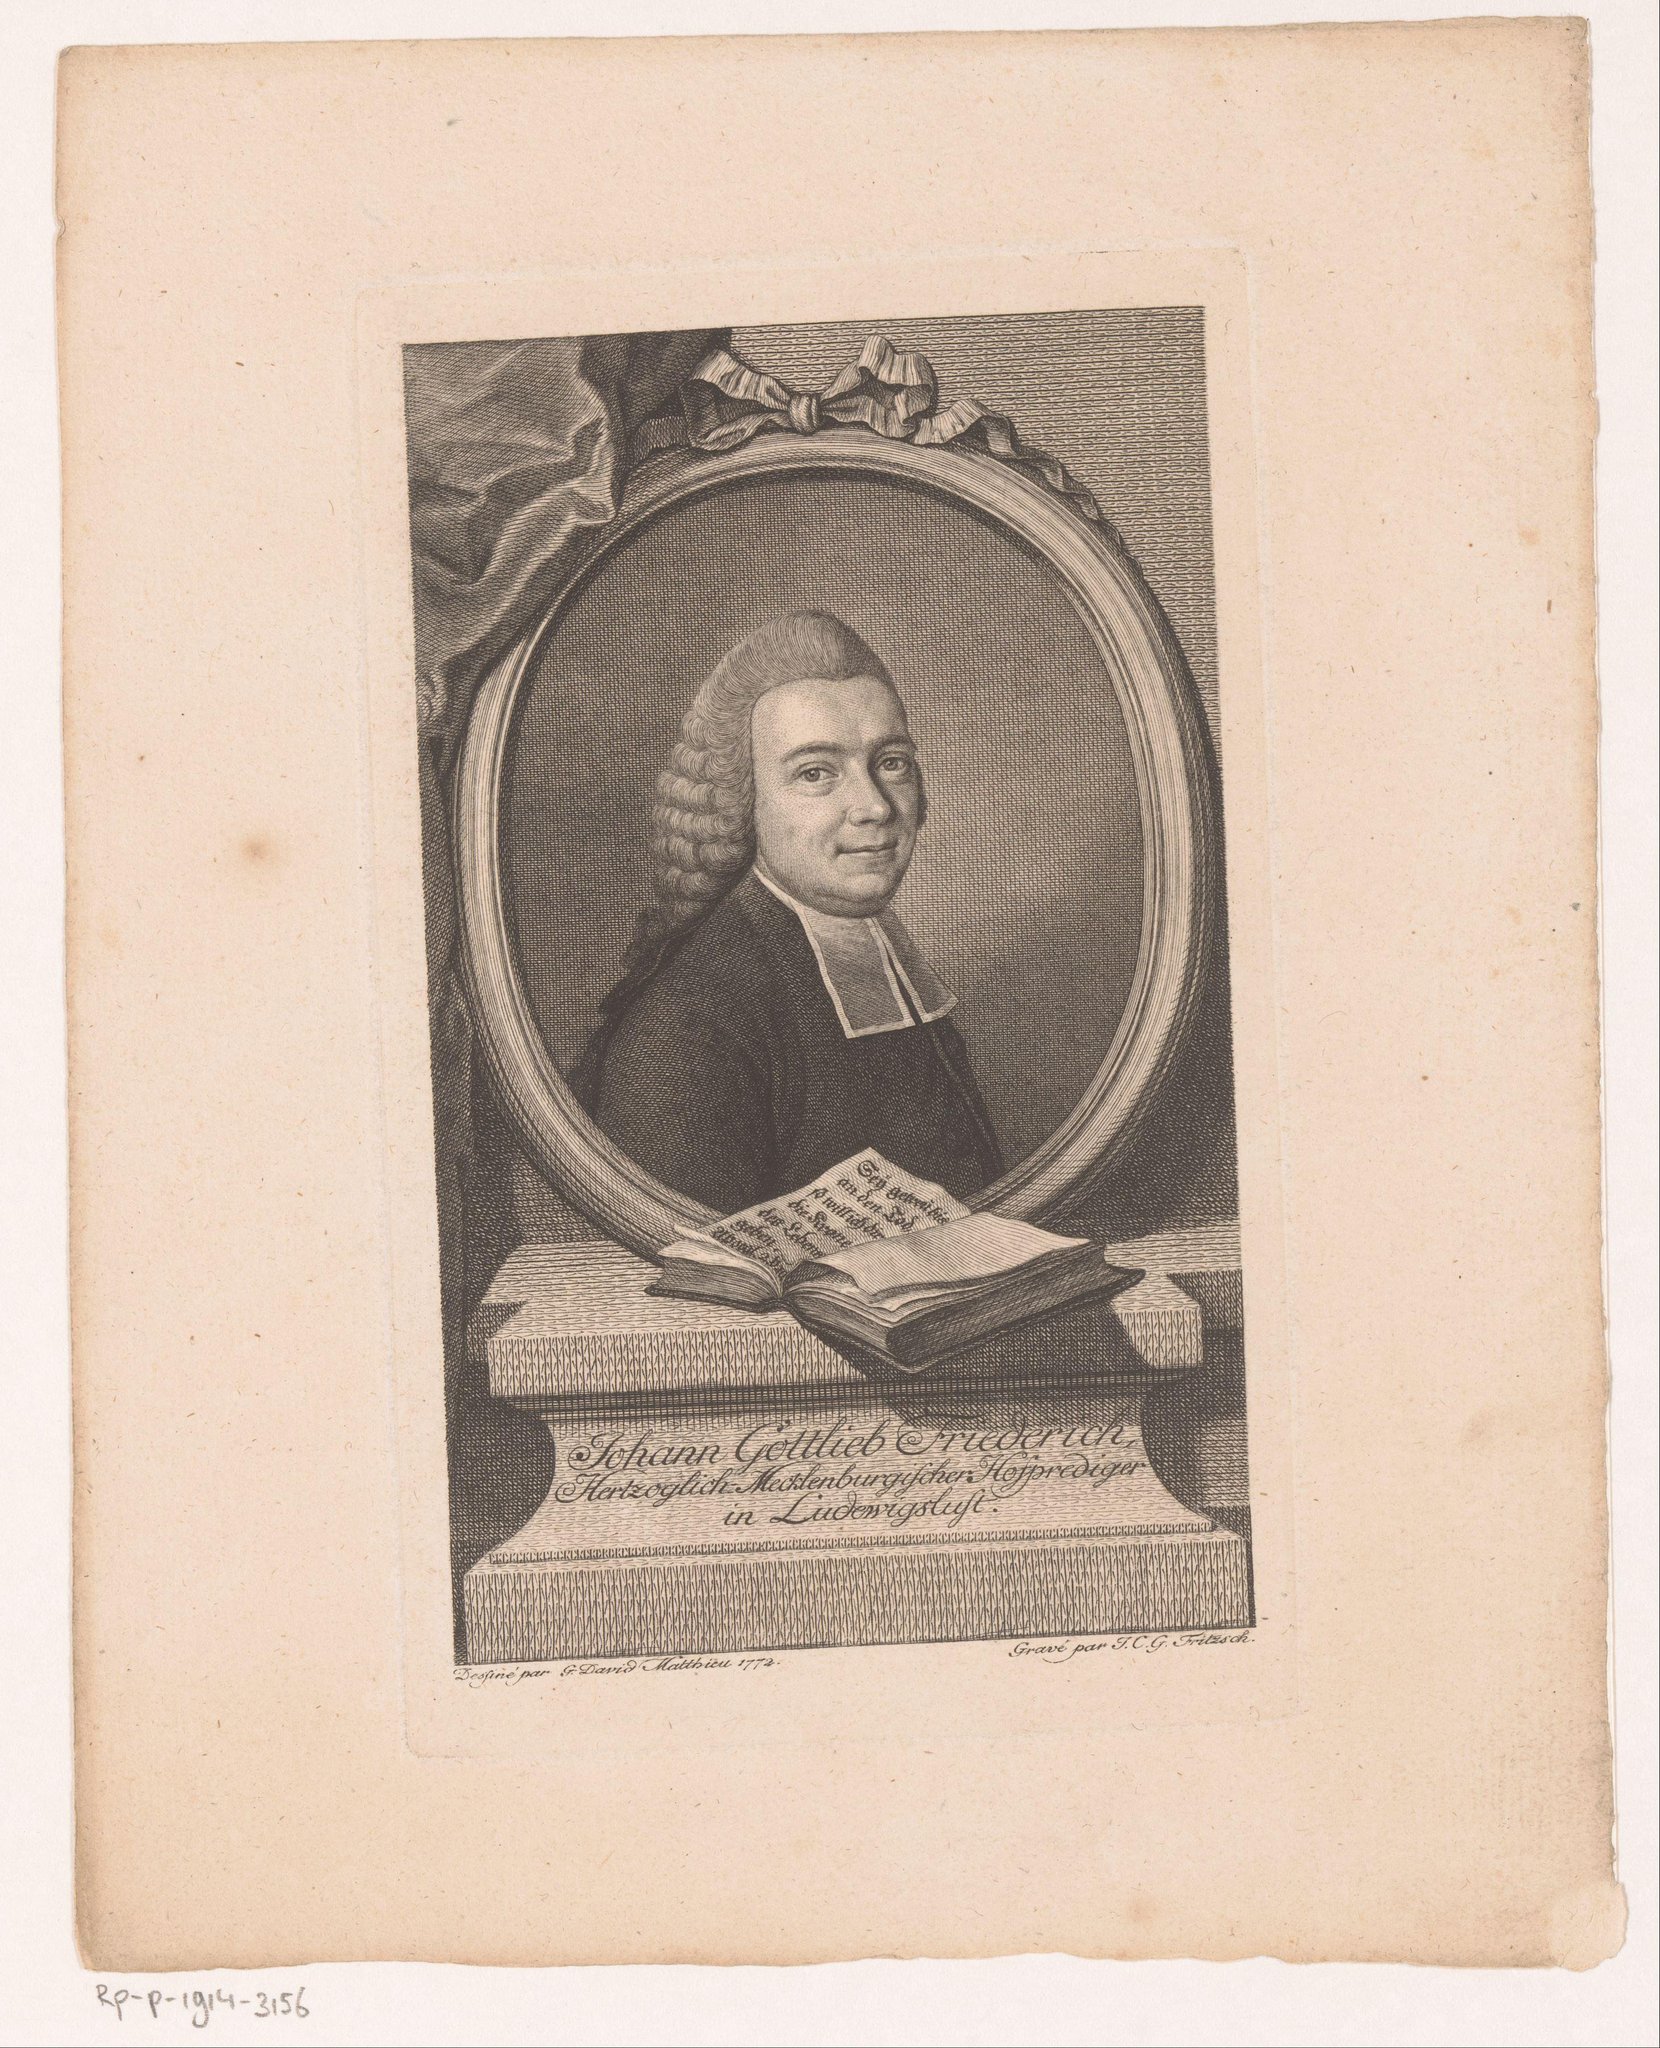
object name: print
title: Portret van Johann Gottlieb Friederich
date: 1772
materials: paper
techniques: engraving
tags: ornament ~ medallion, historical persons, book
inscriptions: collector's mark: Lugt 2228